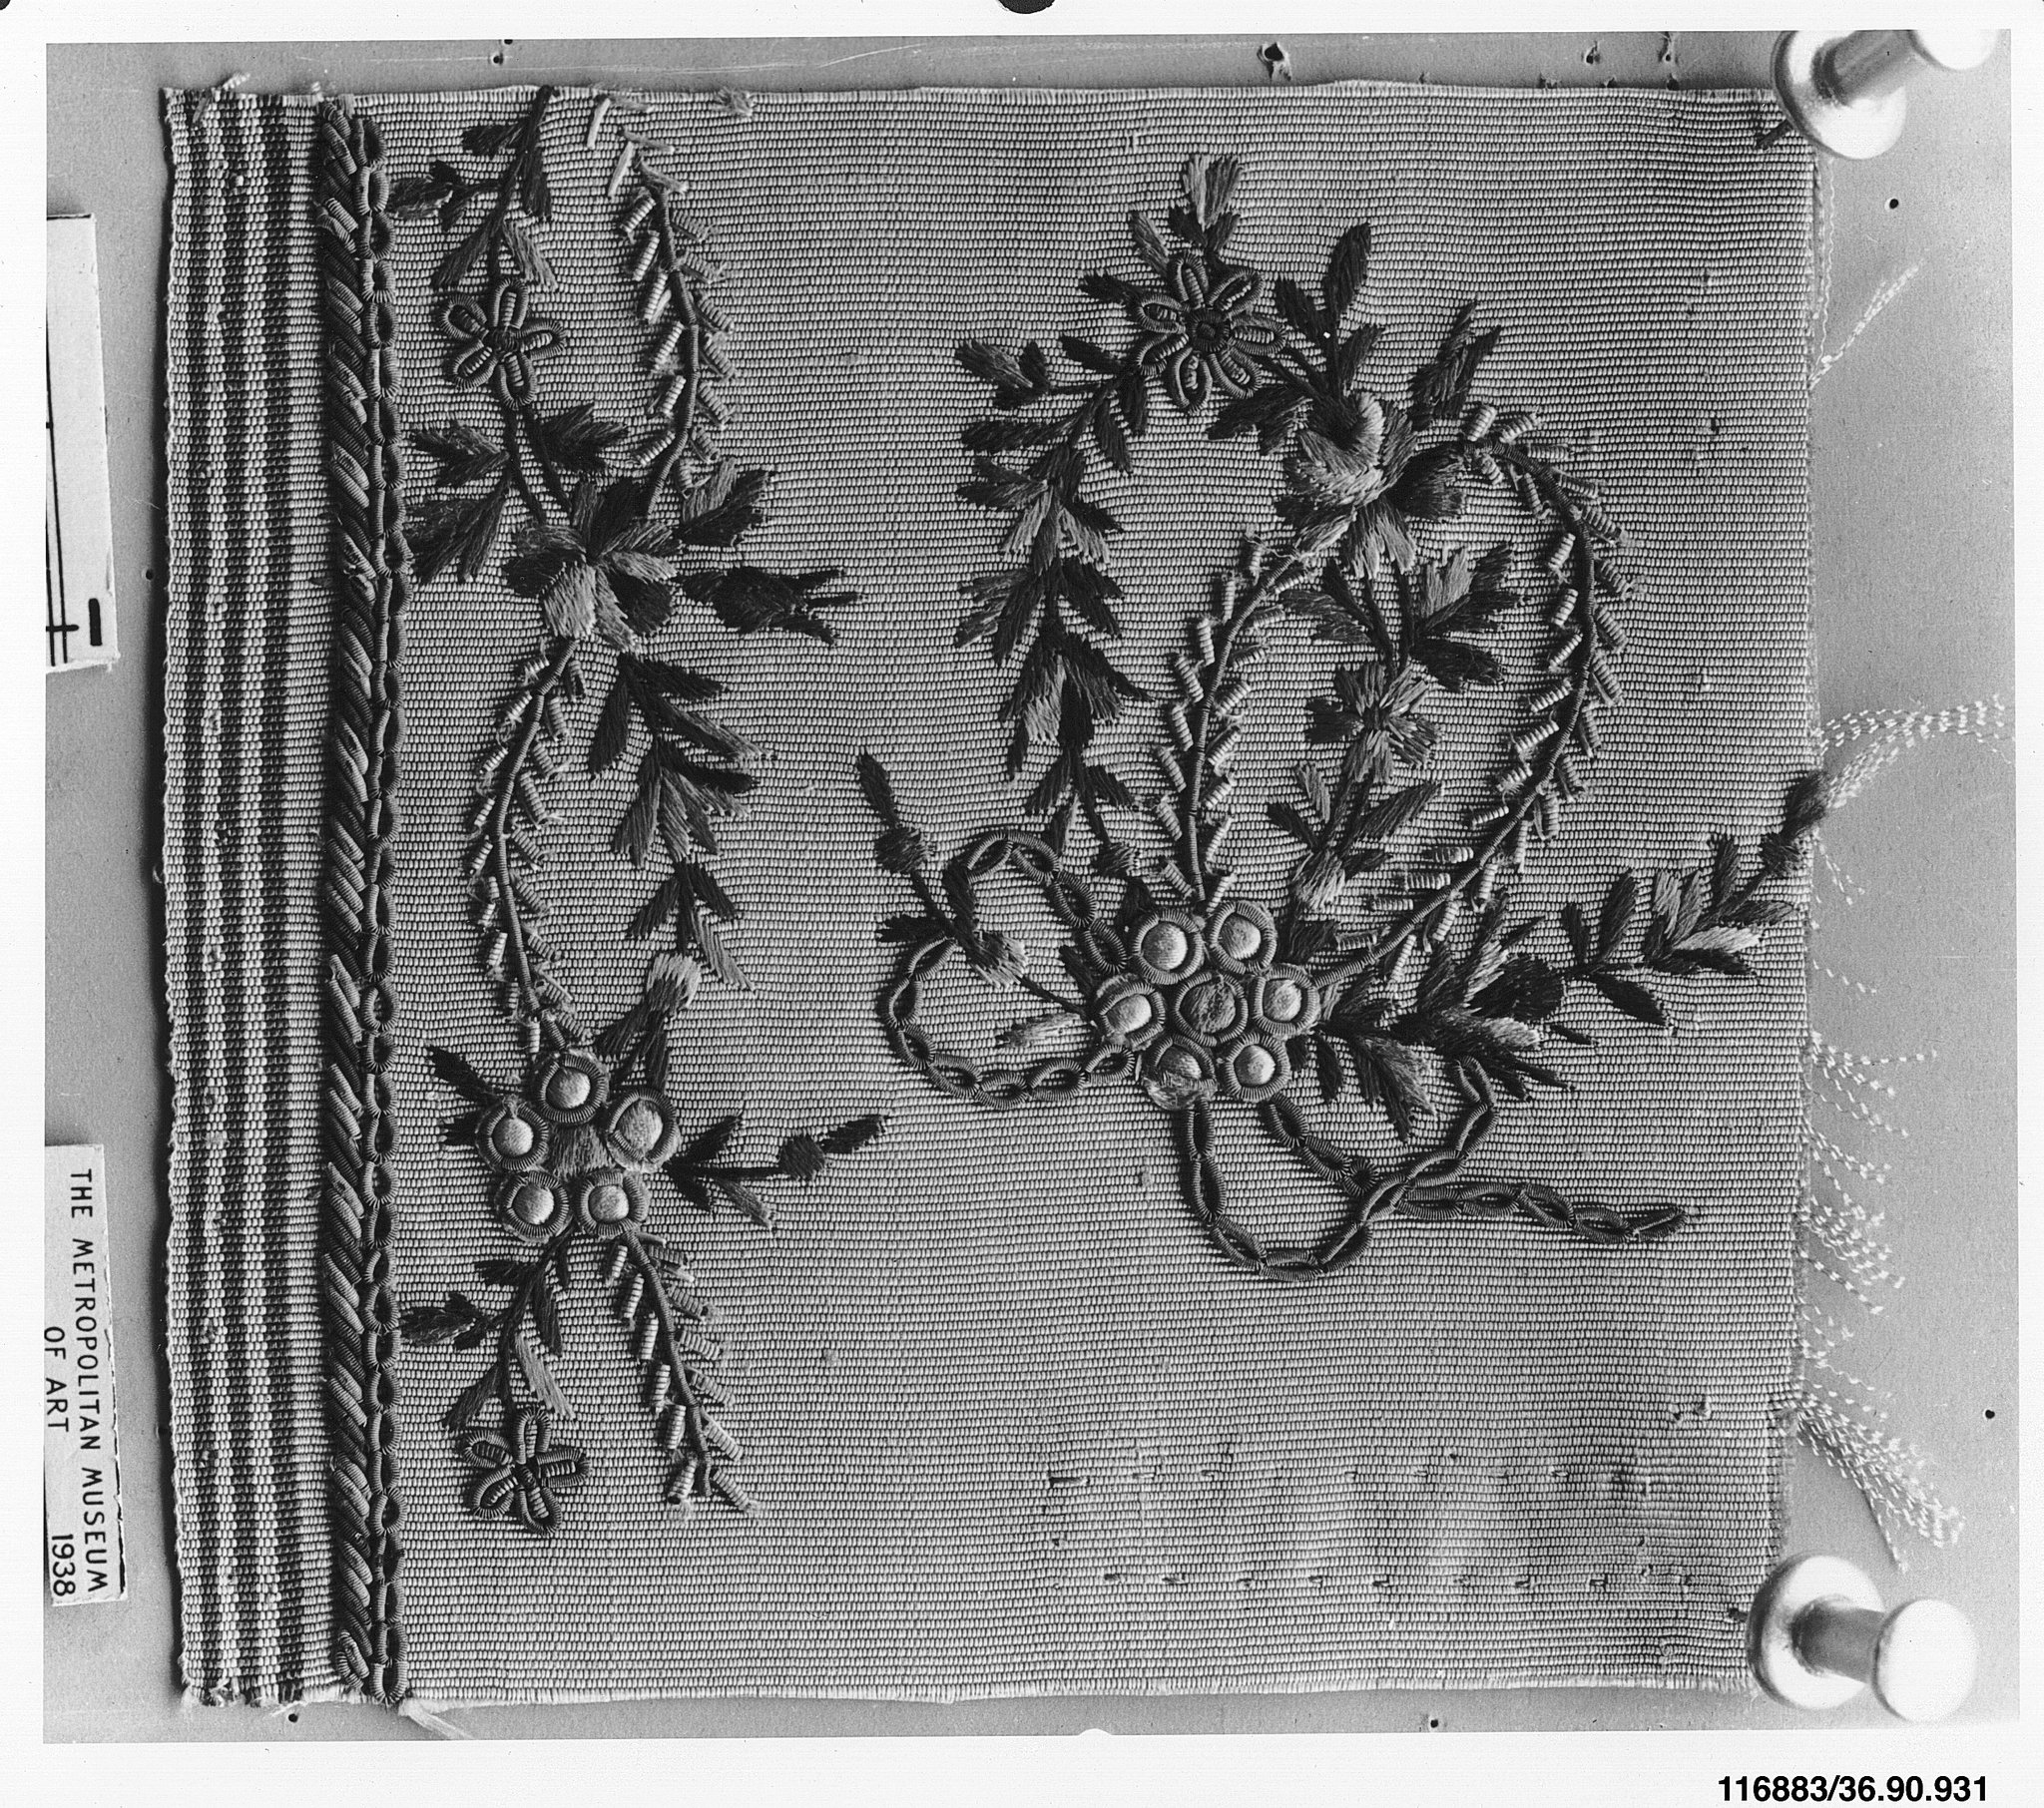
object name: sample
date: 1801-1833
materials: silk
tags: flowers